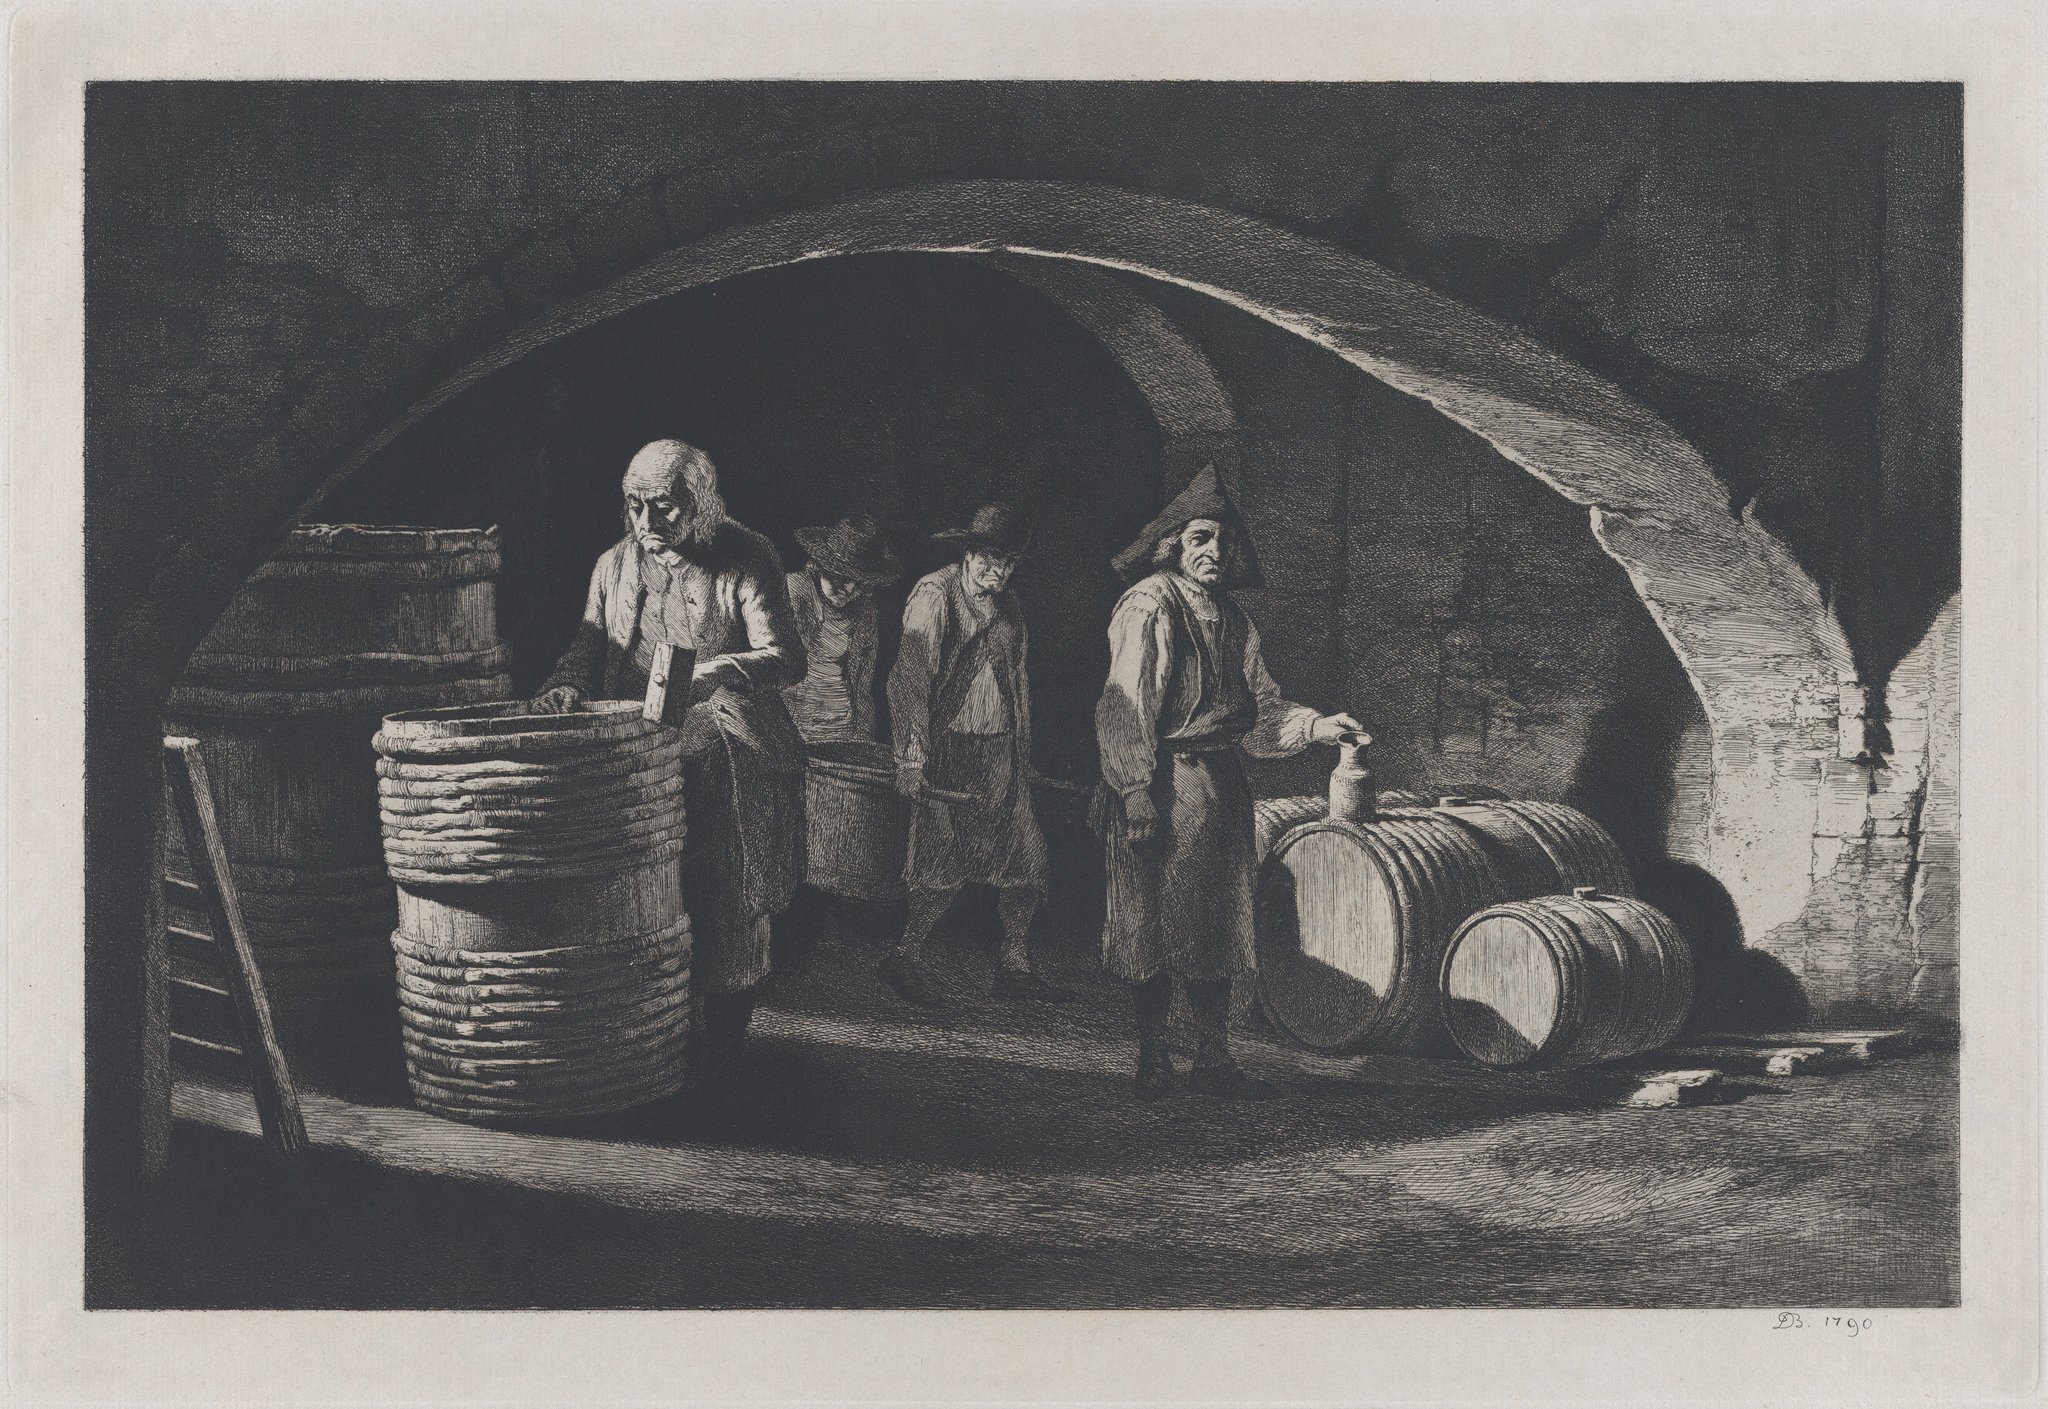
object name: print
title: The Coopers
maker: jean jacques de boissieu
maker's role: artist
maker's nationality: french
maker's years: 1736-1810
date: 1867-1900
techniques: etching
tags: men,working